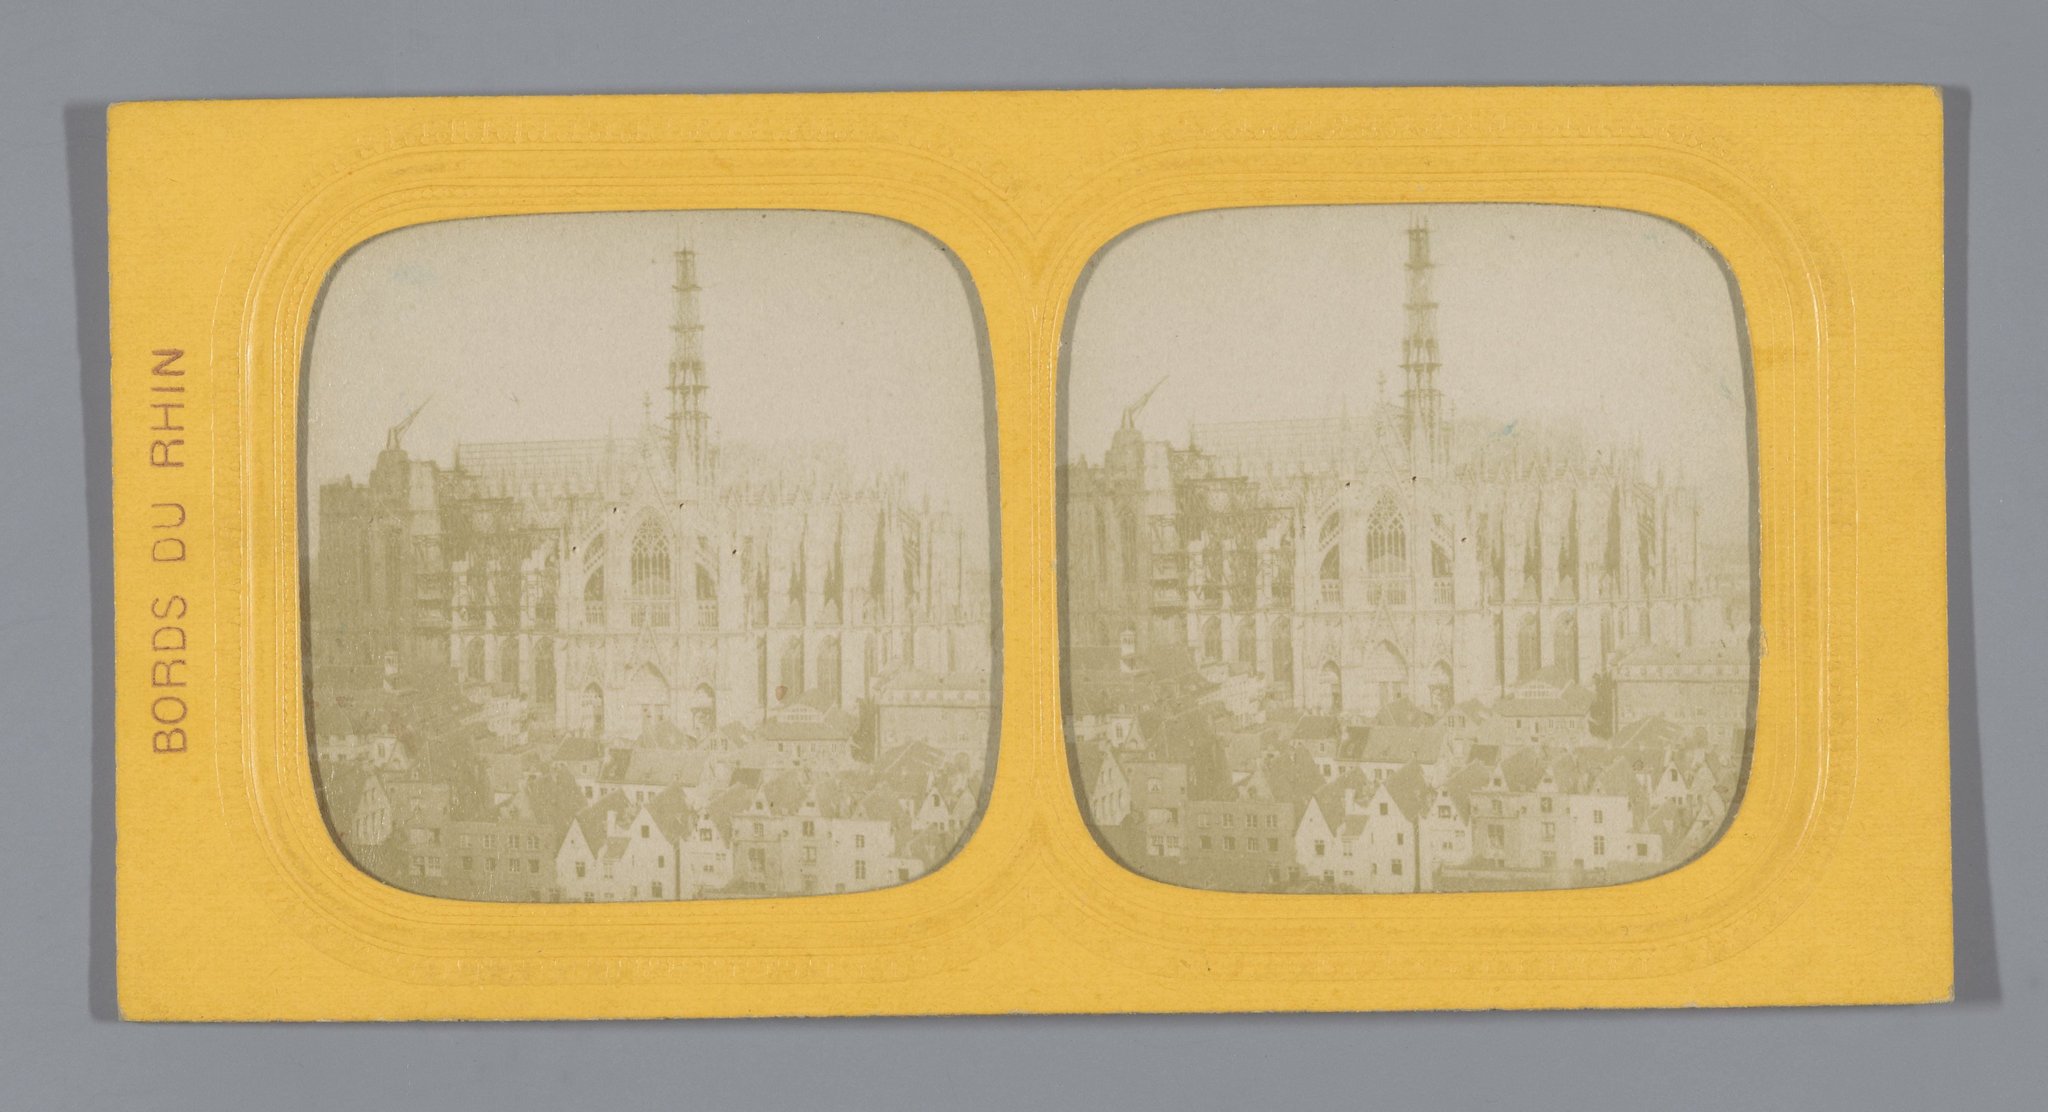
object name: tissue stereograph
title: Le Cathédrale, Cologne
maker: Anonymous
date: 1865-1875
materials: cardboard, paper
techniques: albumen print, hand coloring, perforating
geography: cologne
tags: church (exterior)